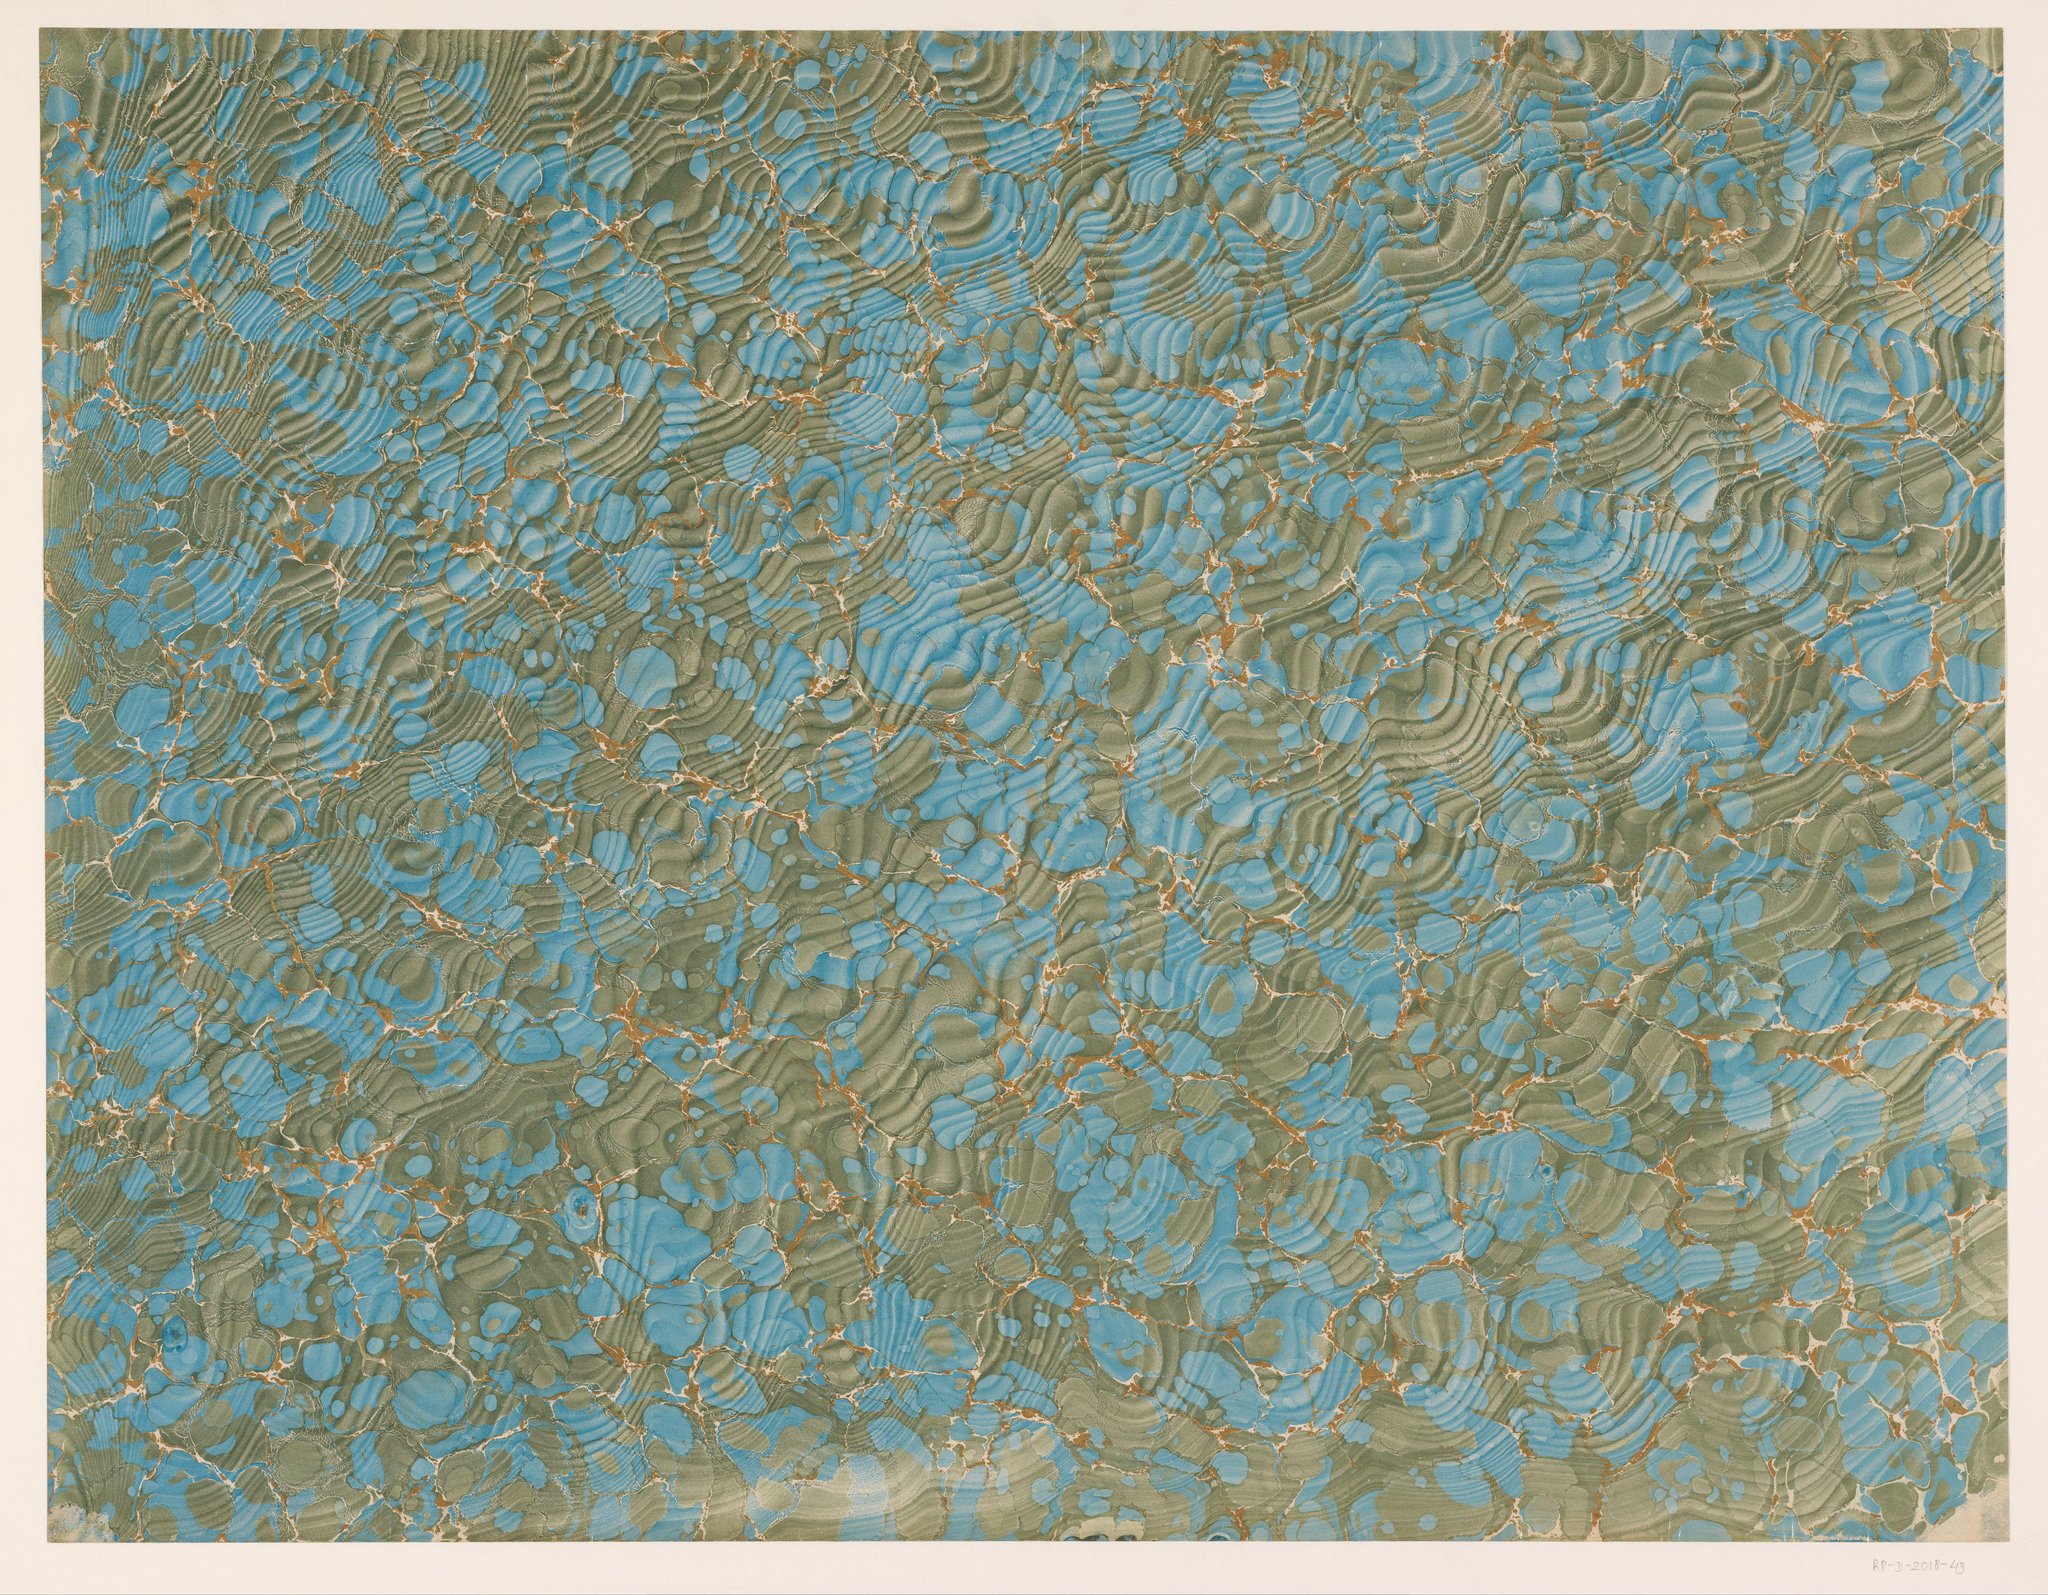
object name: marbled paper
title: Moirémarmer in blauw, groen en goud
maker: Anonymous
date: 1900-2000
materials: paint, lacquer, paper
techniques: marbling